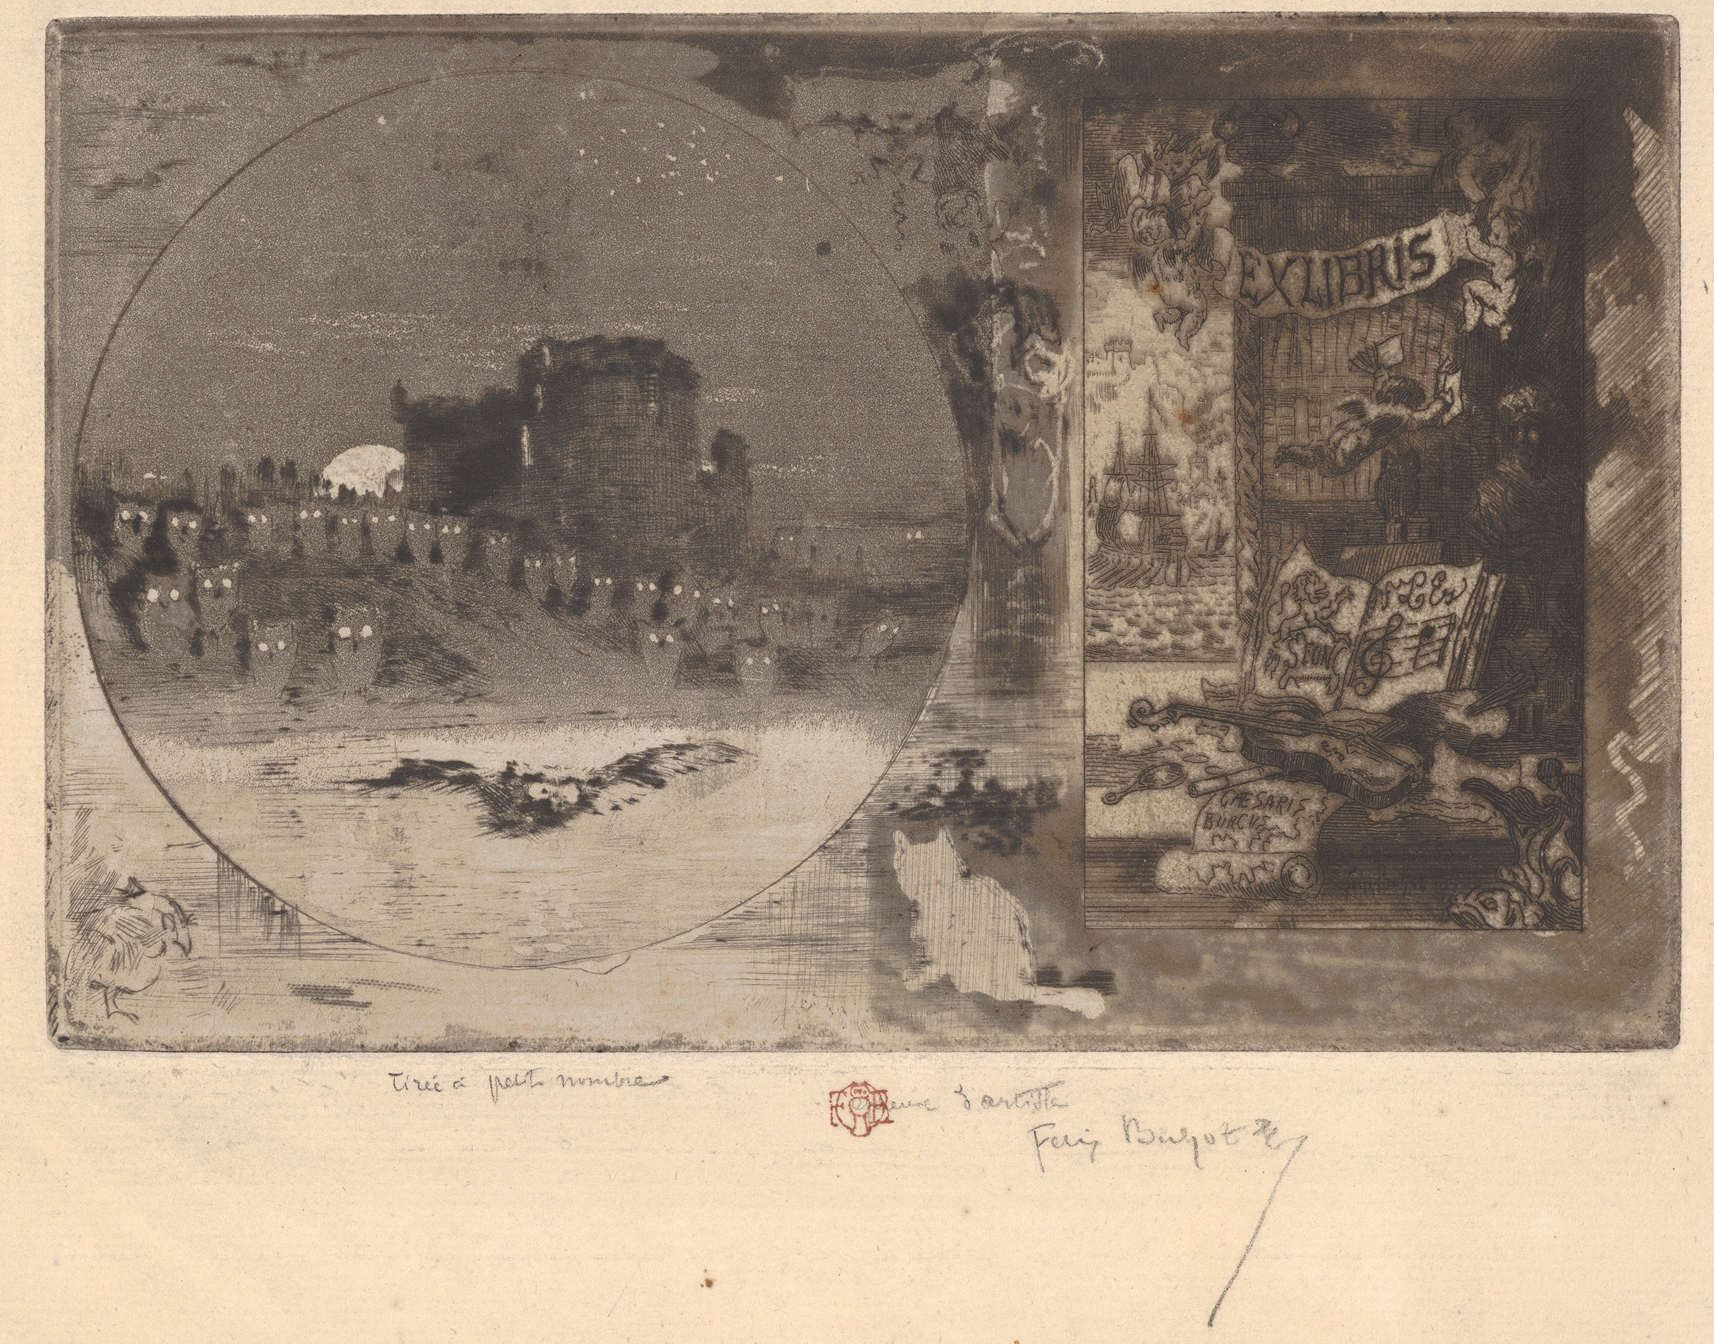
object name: print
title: The Castle of Owls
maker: félix-hilaire buhot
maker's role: artist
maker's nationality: french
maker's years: 1847-1898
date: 1801-1900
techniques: aquatint, drypoint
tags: castles,night